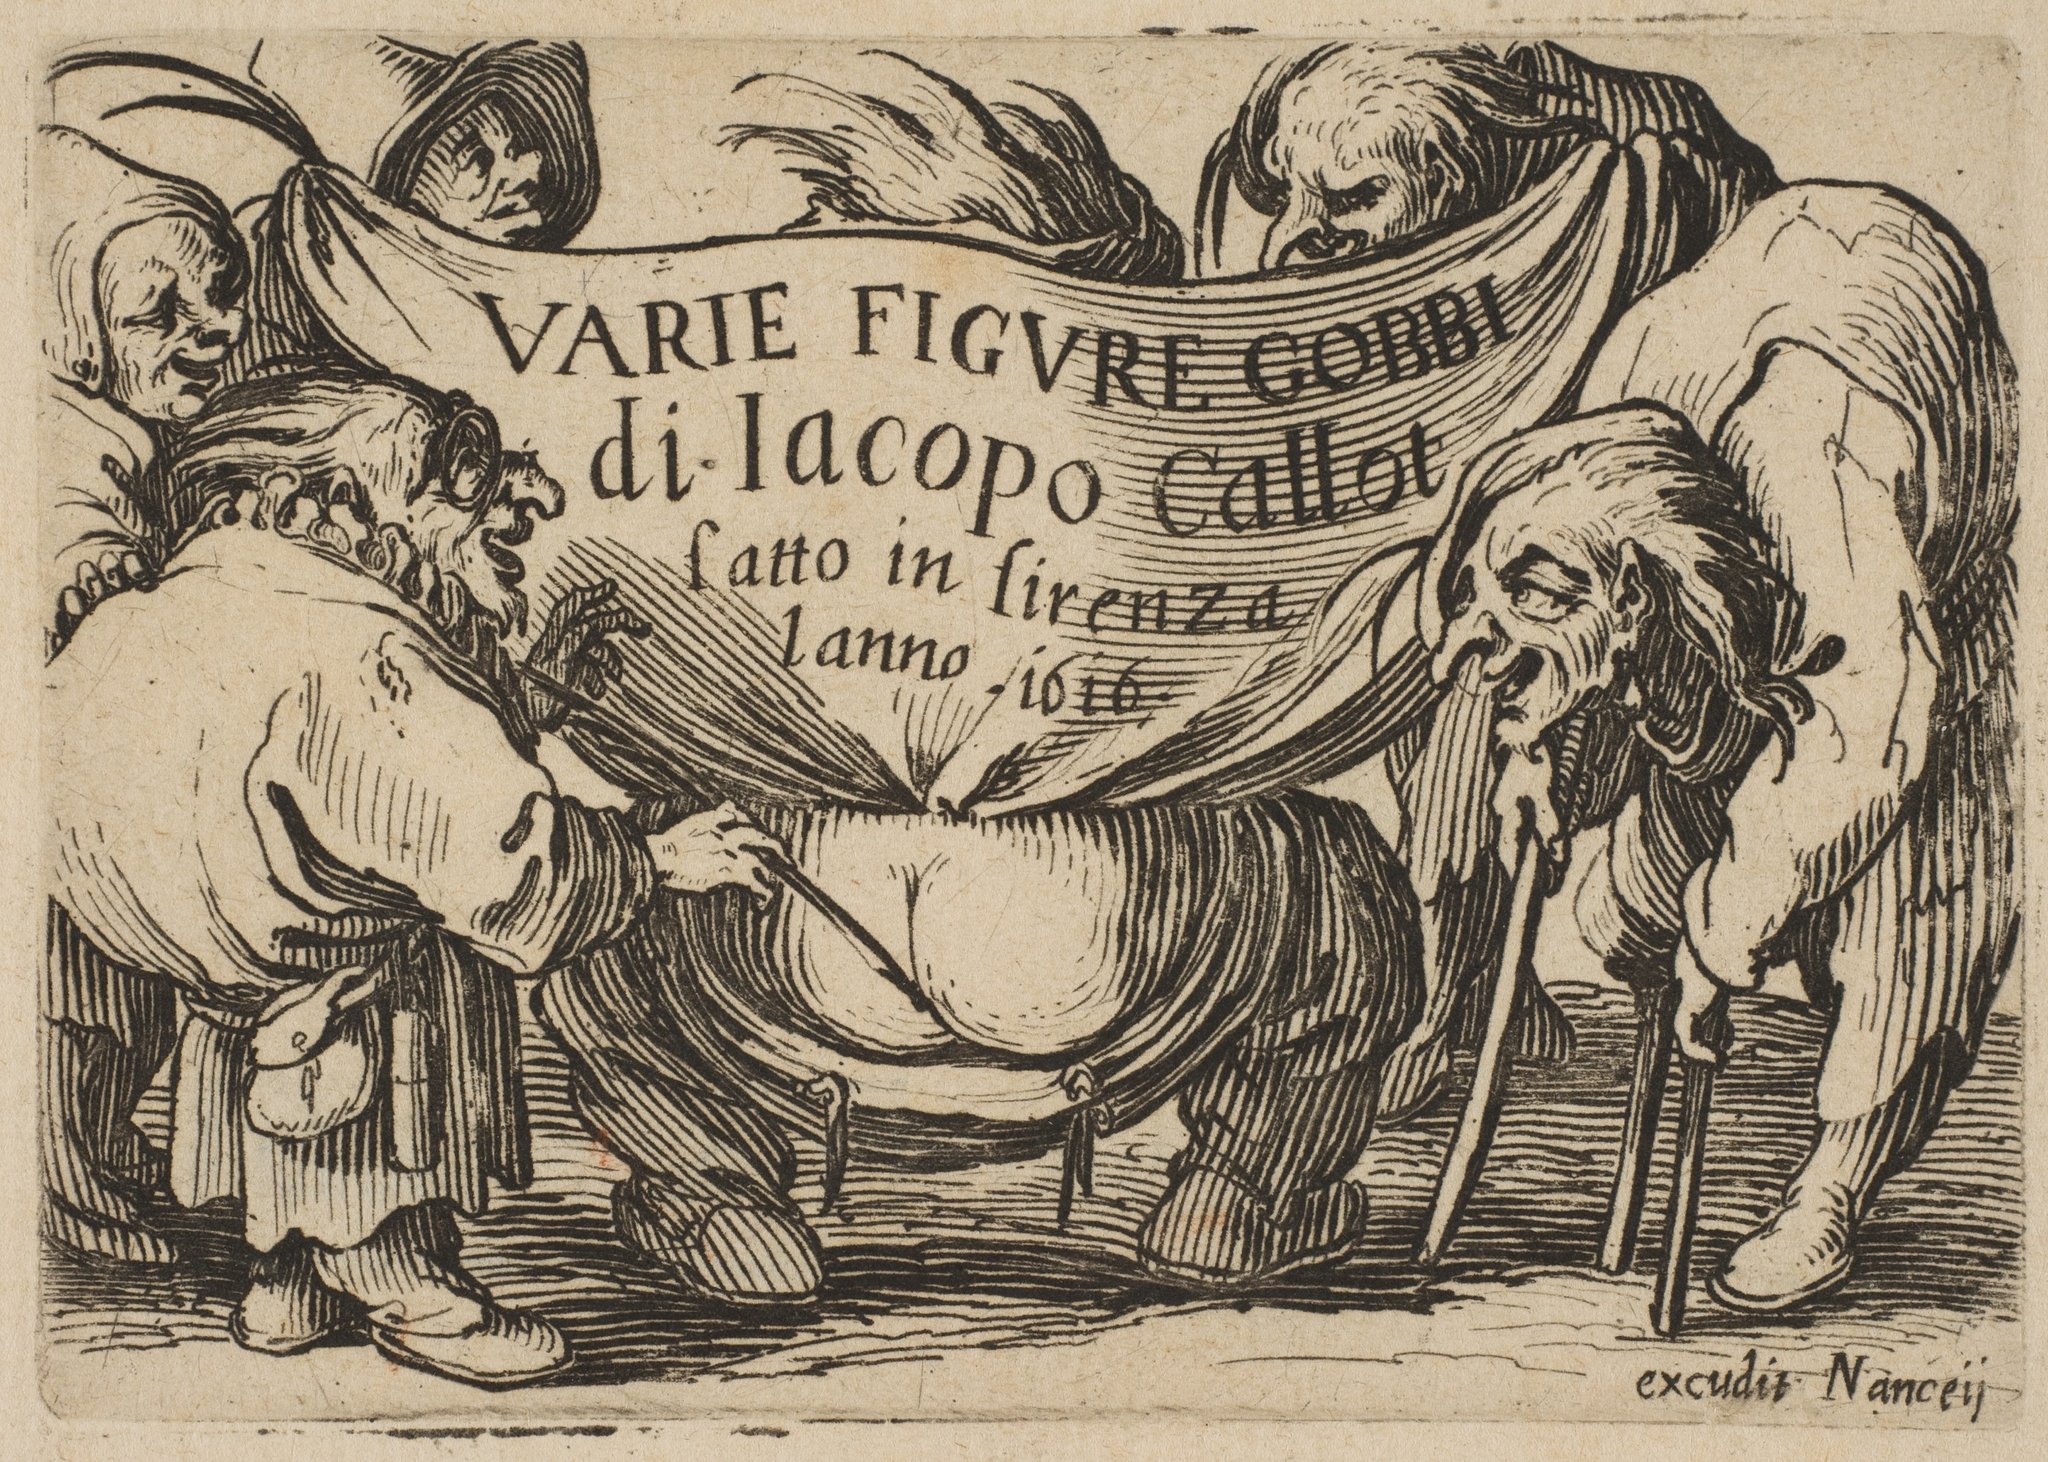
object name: print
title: Frontispiece, from "Varie Figure Gobbi, suite appelée aussi Les Bossus, Les Pygmées, Les Nains Grotesques" (Various Hunchbacked Figures, The Hunchbacks, The Pygmes, The Grotesque Dwarfs)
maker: jacques callot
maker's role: artist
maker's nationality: french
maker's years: 1592-1635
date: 1616-1622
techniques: engraving, etching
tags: human figures